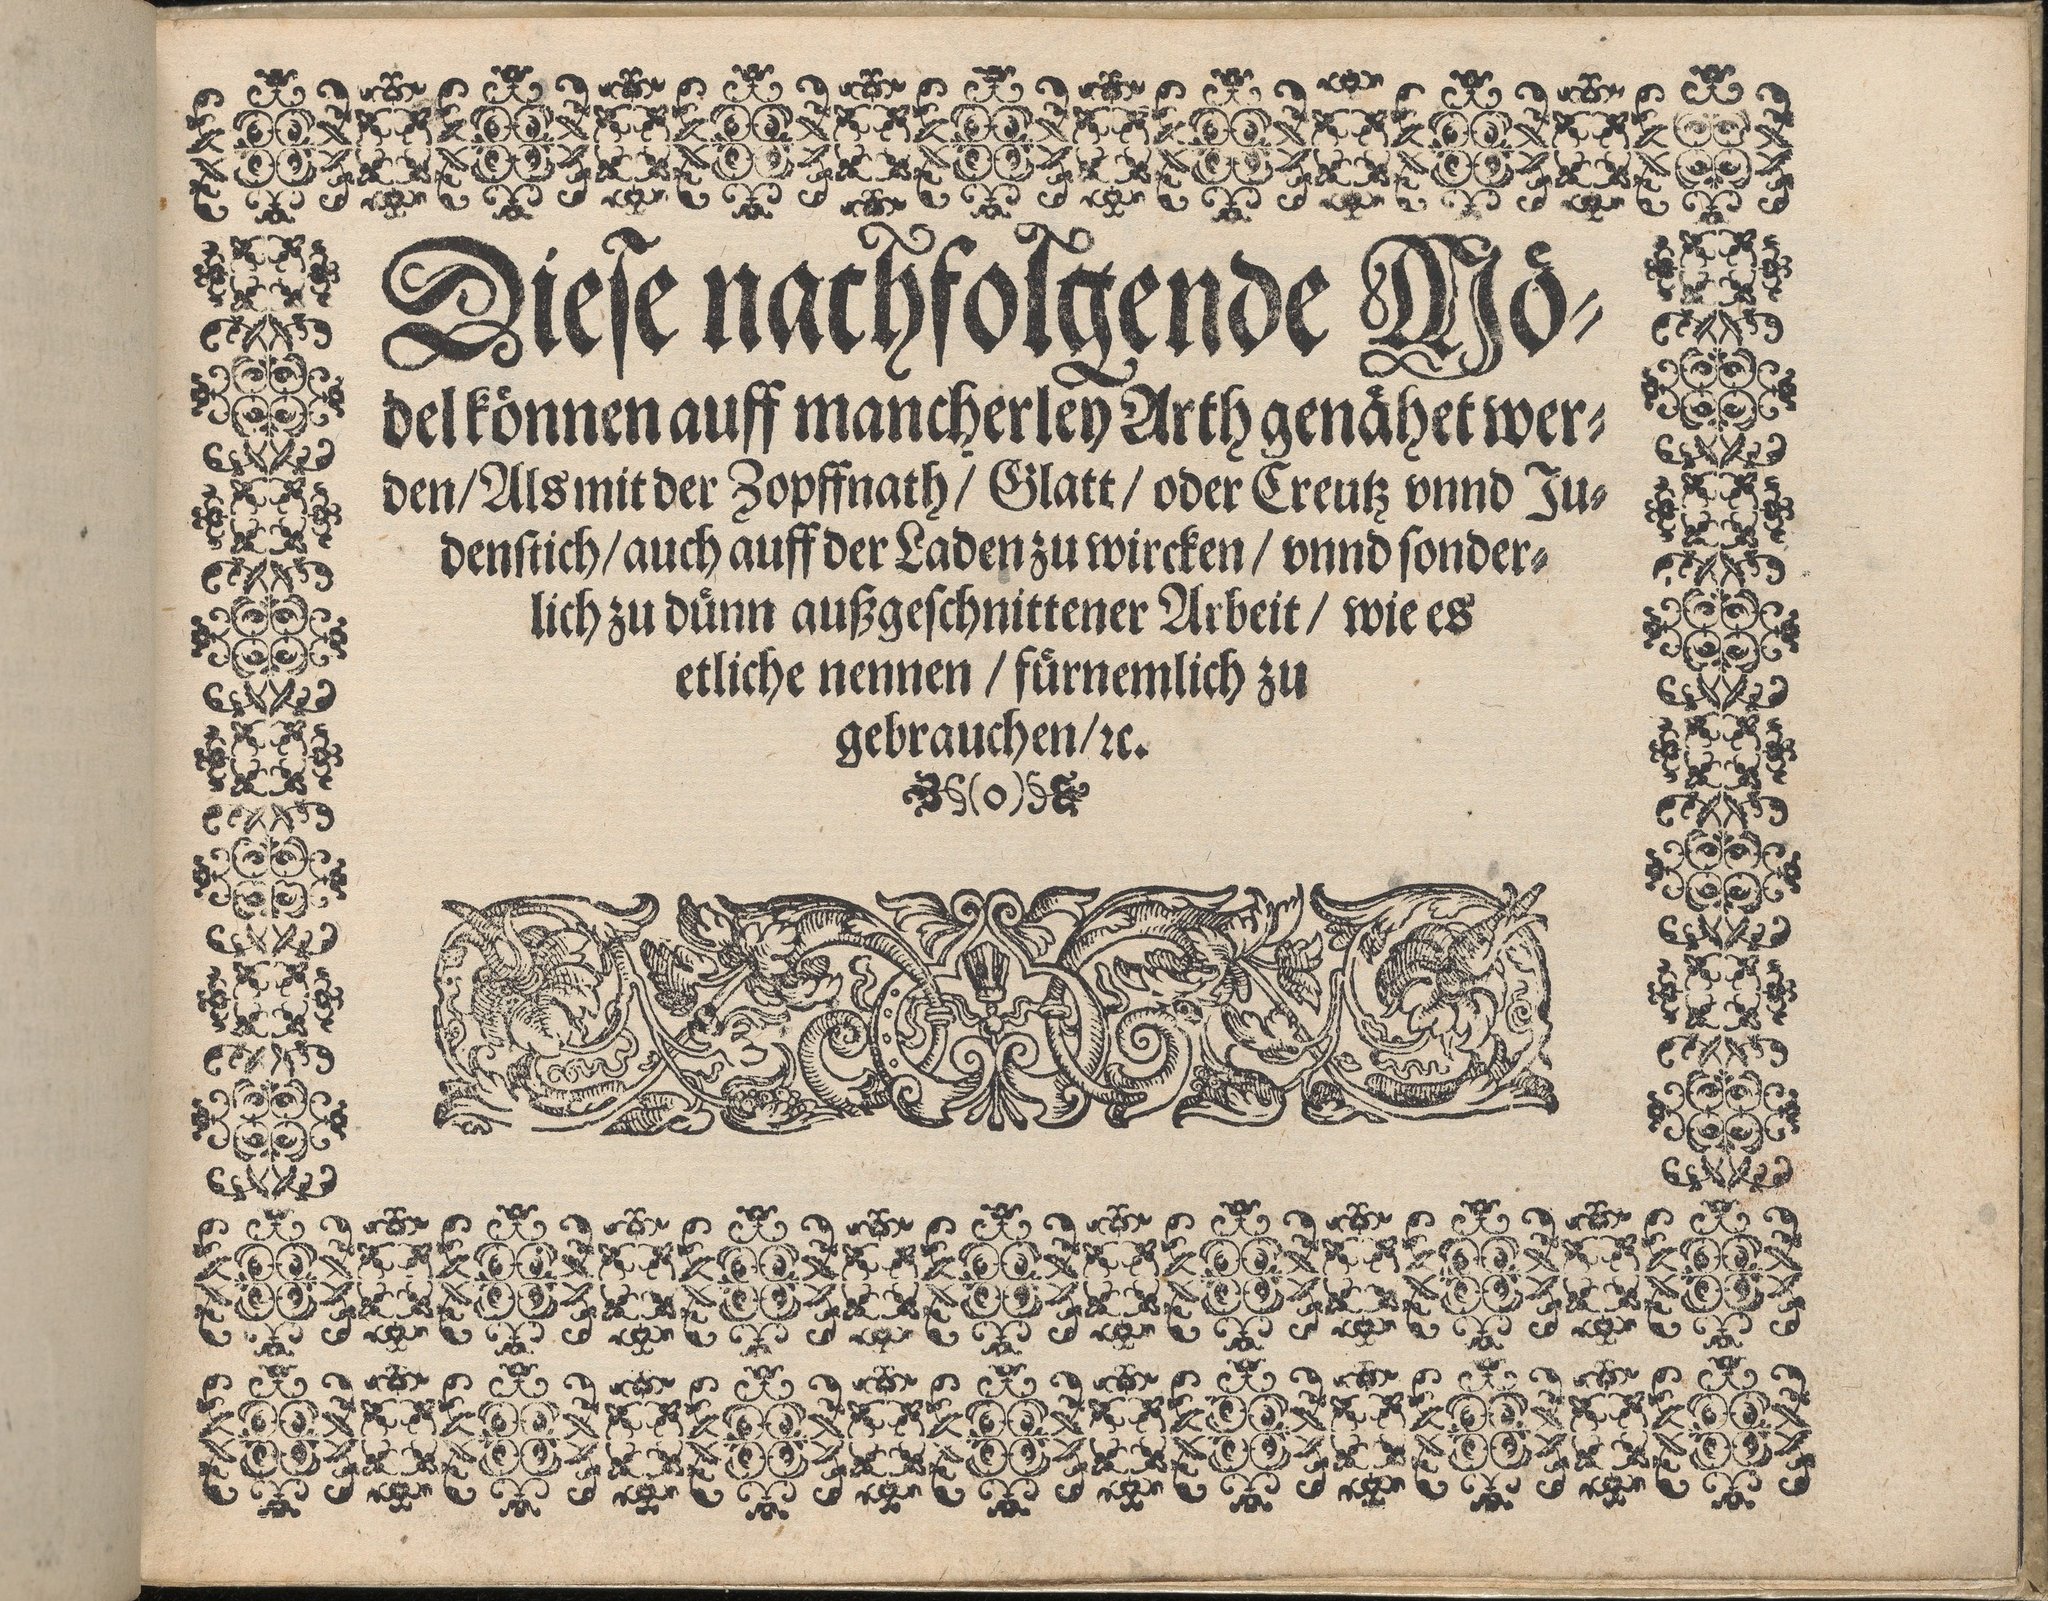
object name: book print ornament architecture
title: Newes Modelbuch in Kupffer (Page 9r)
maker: johann sibmacher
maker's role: artist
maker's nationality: german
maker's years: 1590-1611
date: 1604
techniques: woodcut